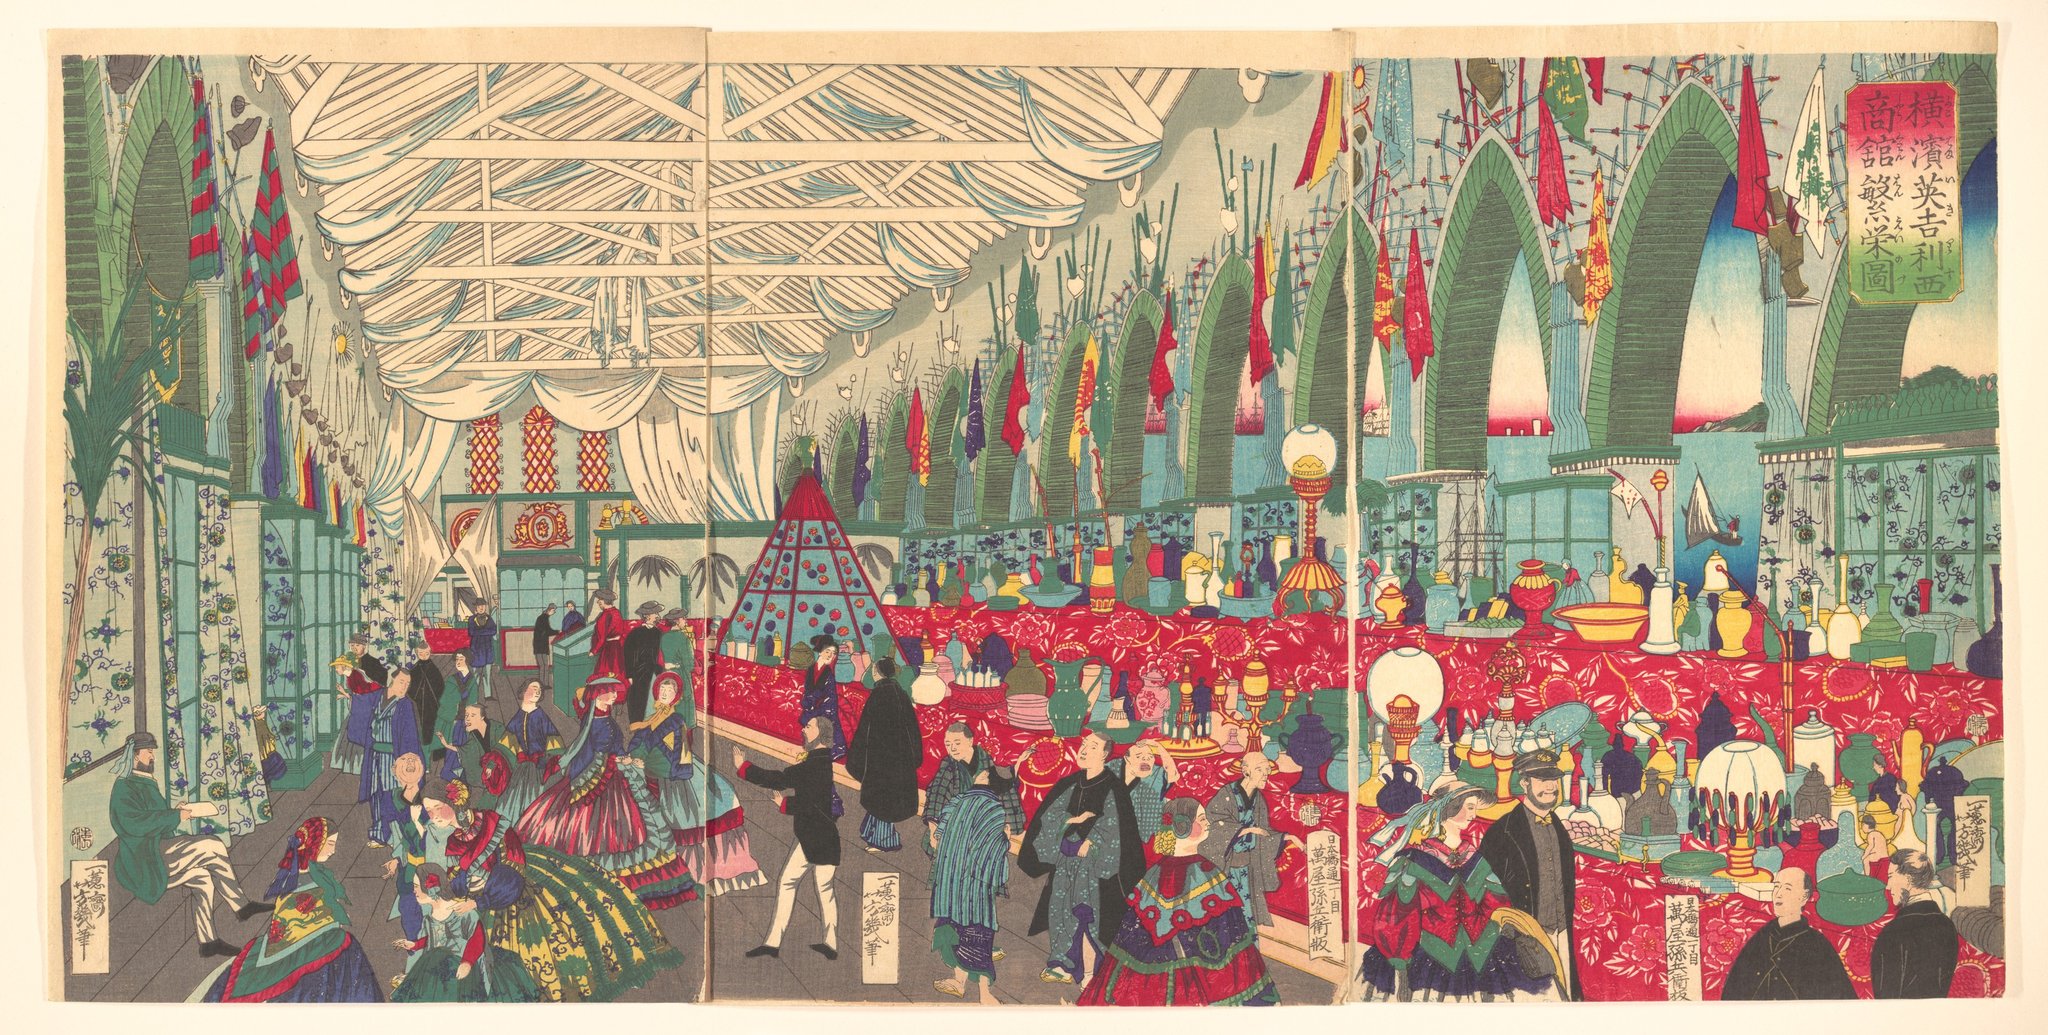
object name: print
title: “The Flourishing of an English Trading Firm in Yokohama”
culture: japanese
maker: utagawa yoshiiku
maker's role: artist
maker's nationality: japanese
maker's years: 1833-1904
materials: ink, paper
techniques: woodblock print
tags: men,women,crowd,flags